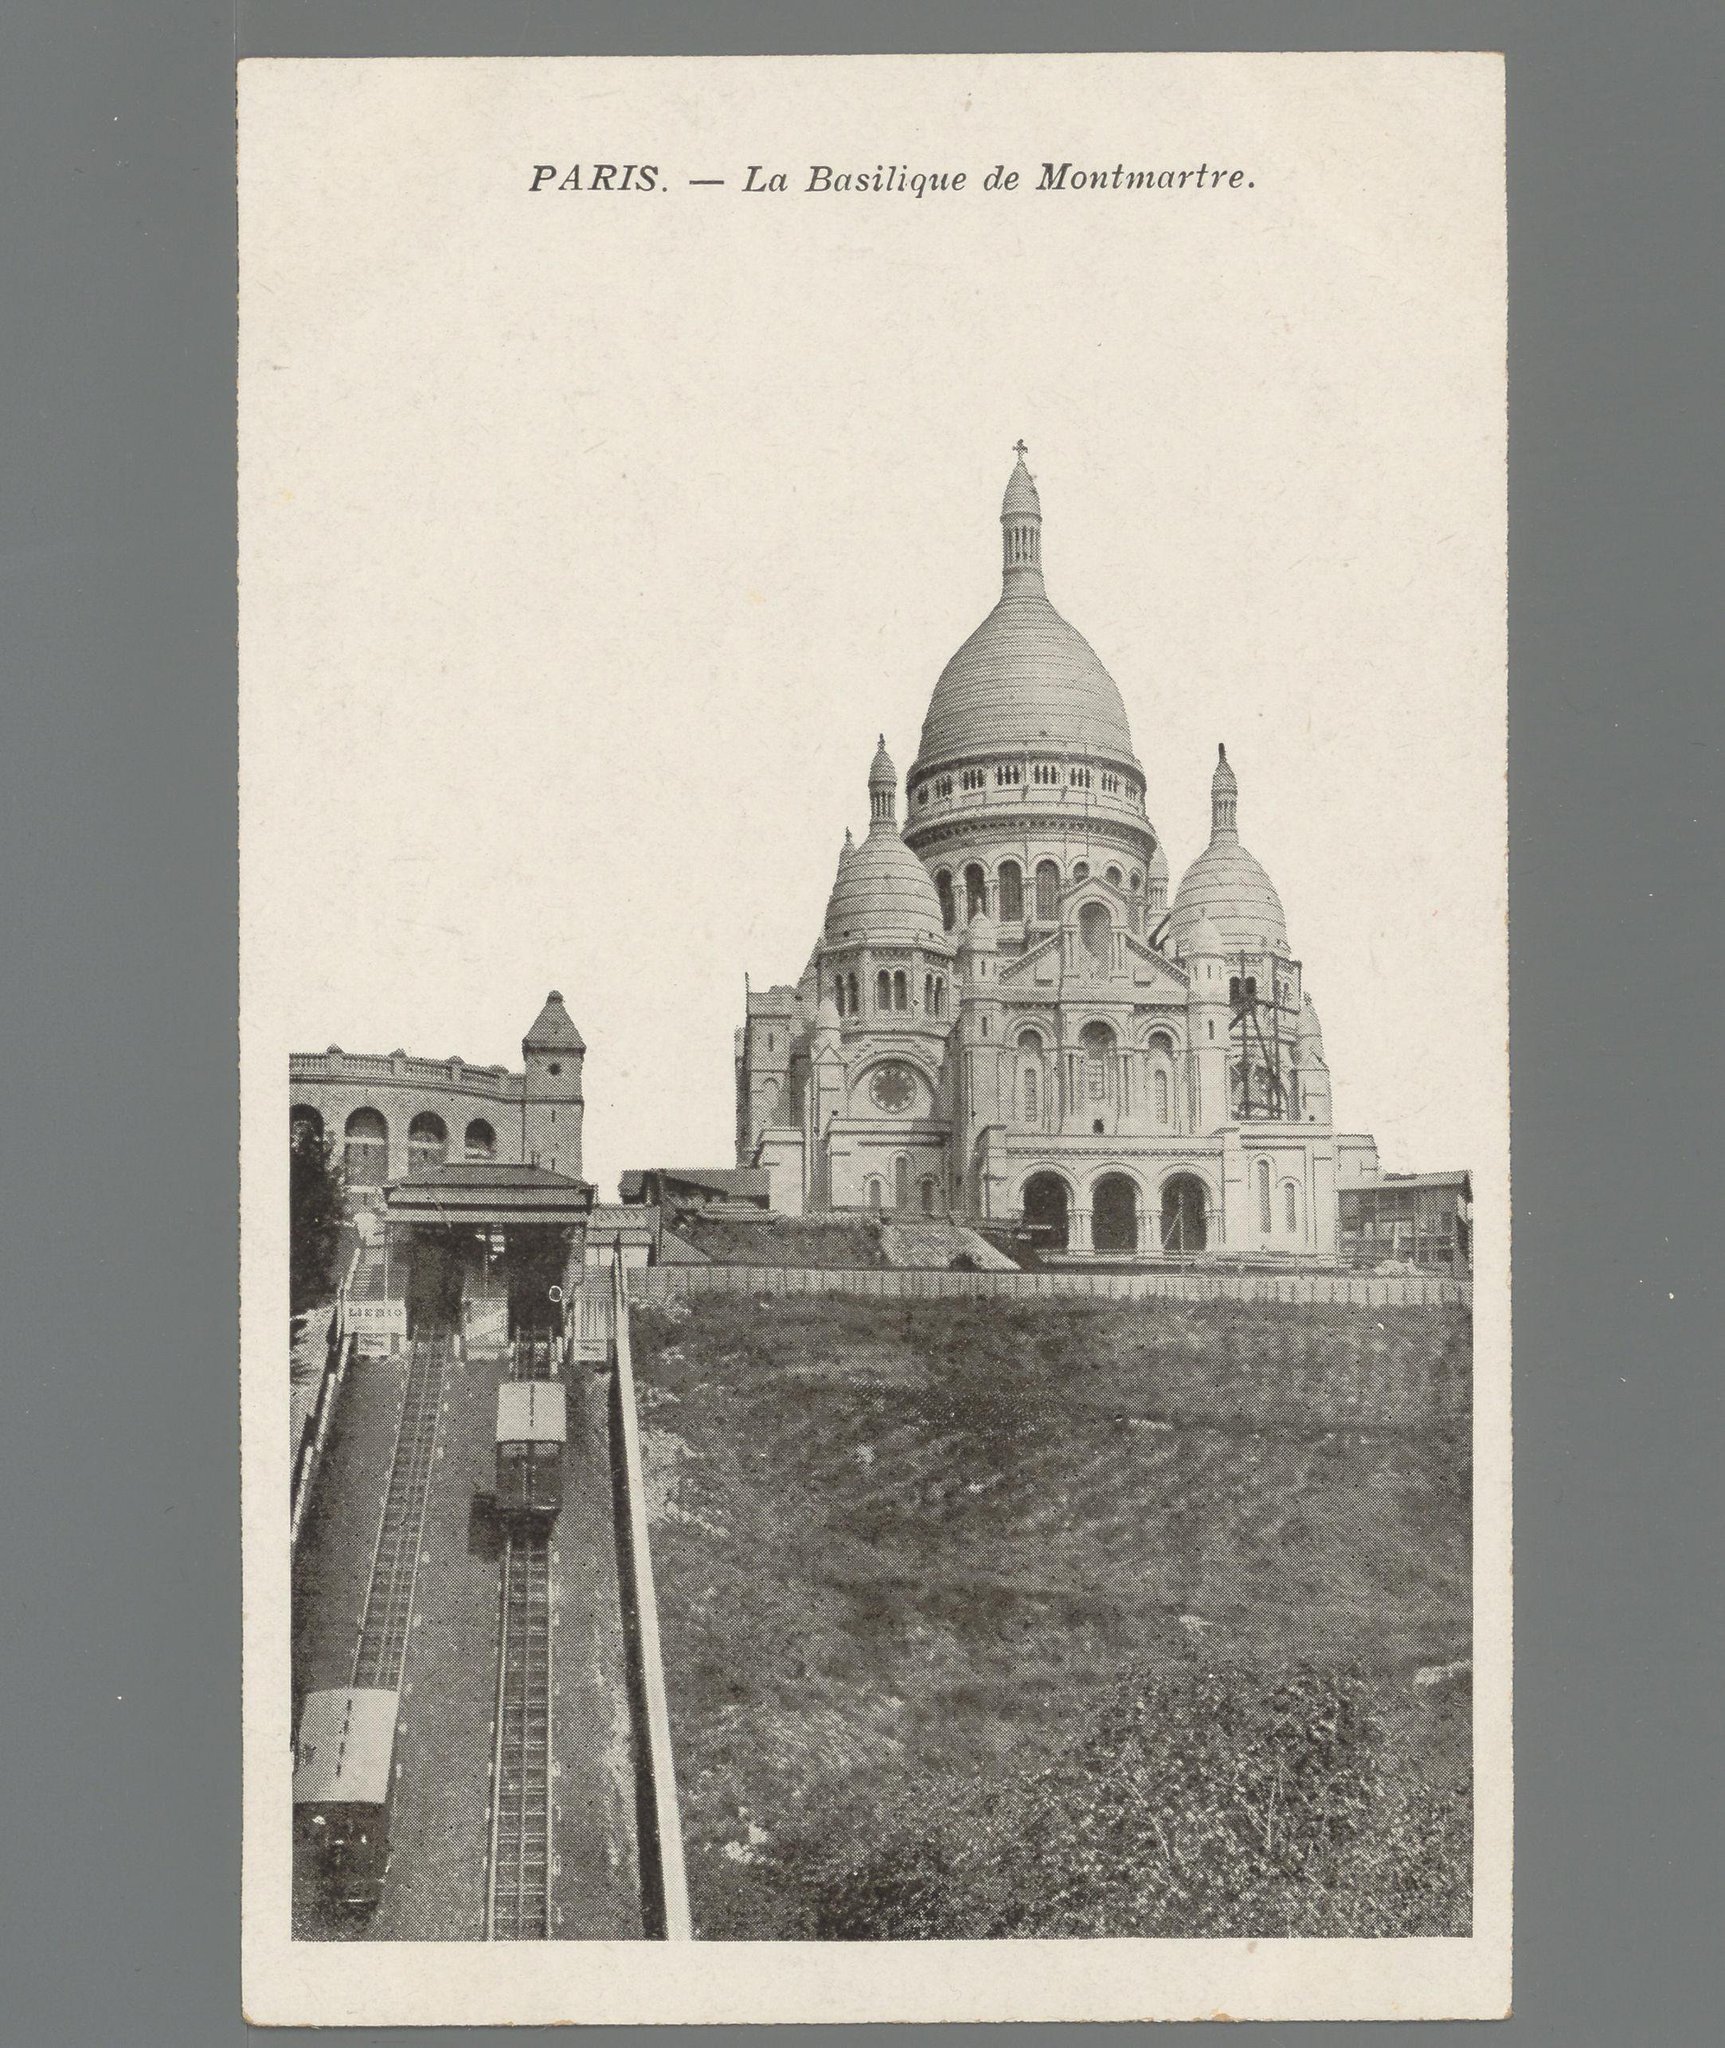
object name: photomechanical print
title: Paris. La Basilique de Montmartre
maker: Anonymous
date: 1904-1906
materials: cardboard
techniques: autotype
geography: paris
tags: funicular railway, church (exterior)